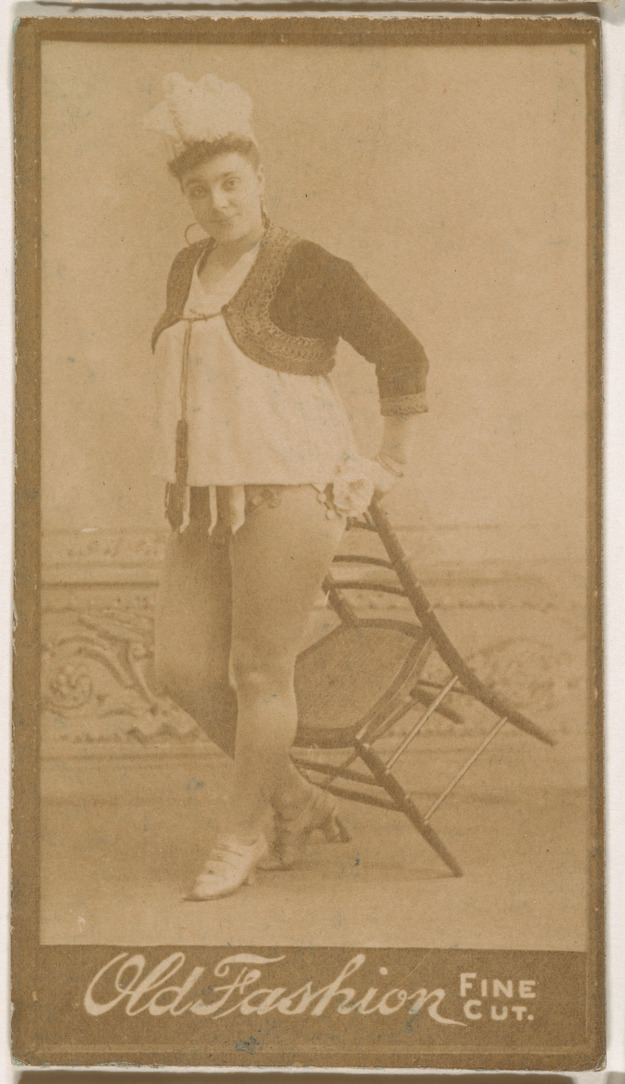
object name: photograph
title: Actress posing with tilted chair, from the Actresses series (N664) promoting Old Fashion Fine Cut Tobacco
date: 1888-1890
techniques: albumen silver print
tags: portraits,women,actresses